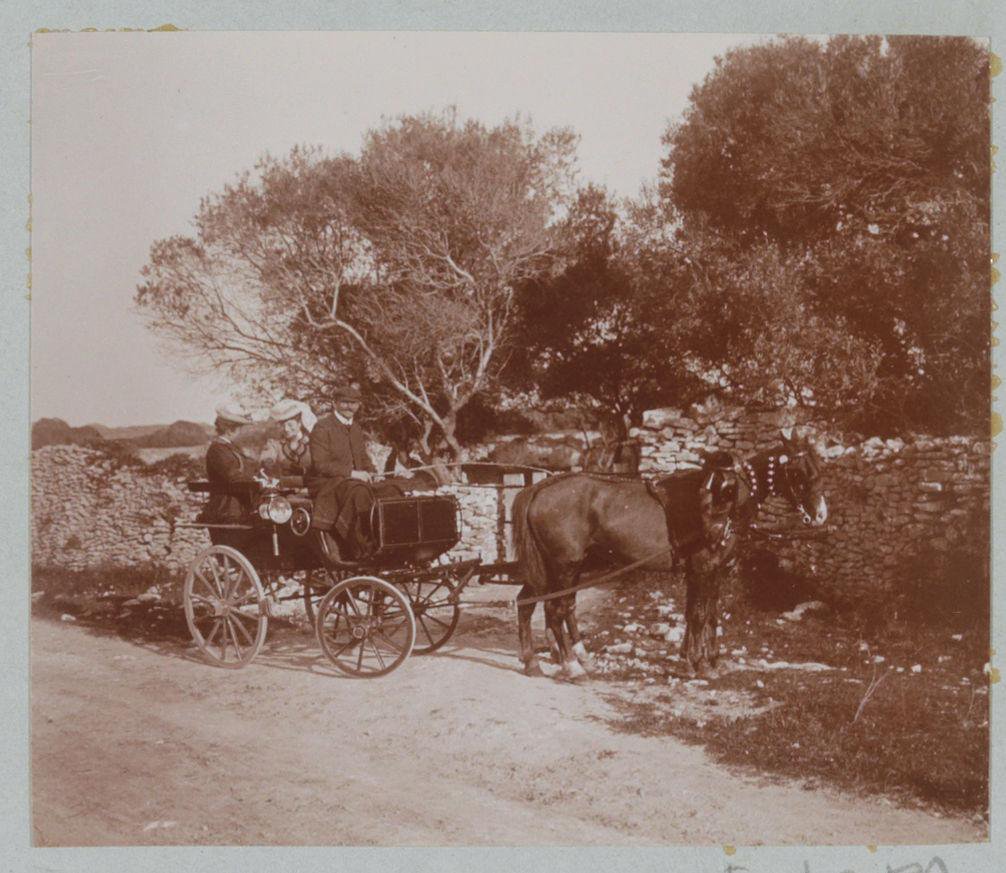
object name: photograph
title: Gezelschap in een rijtuig, vermoedelijk op Corsica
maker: Anonymous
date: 1905-1910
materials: paper, photographic support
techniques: gelatin silver print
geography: corsica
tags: four-wheeled, animal-drawn vehicle, e.g.: cab, carriage, coach, travelling; tourism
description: Onderdeel van Fotoalbum van een Franse amateurfotograaf met bezienswaardigheden in Frankrijk, Zwitserland en Italië.